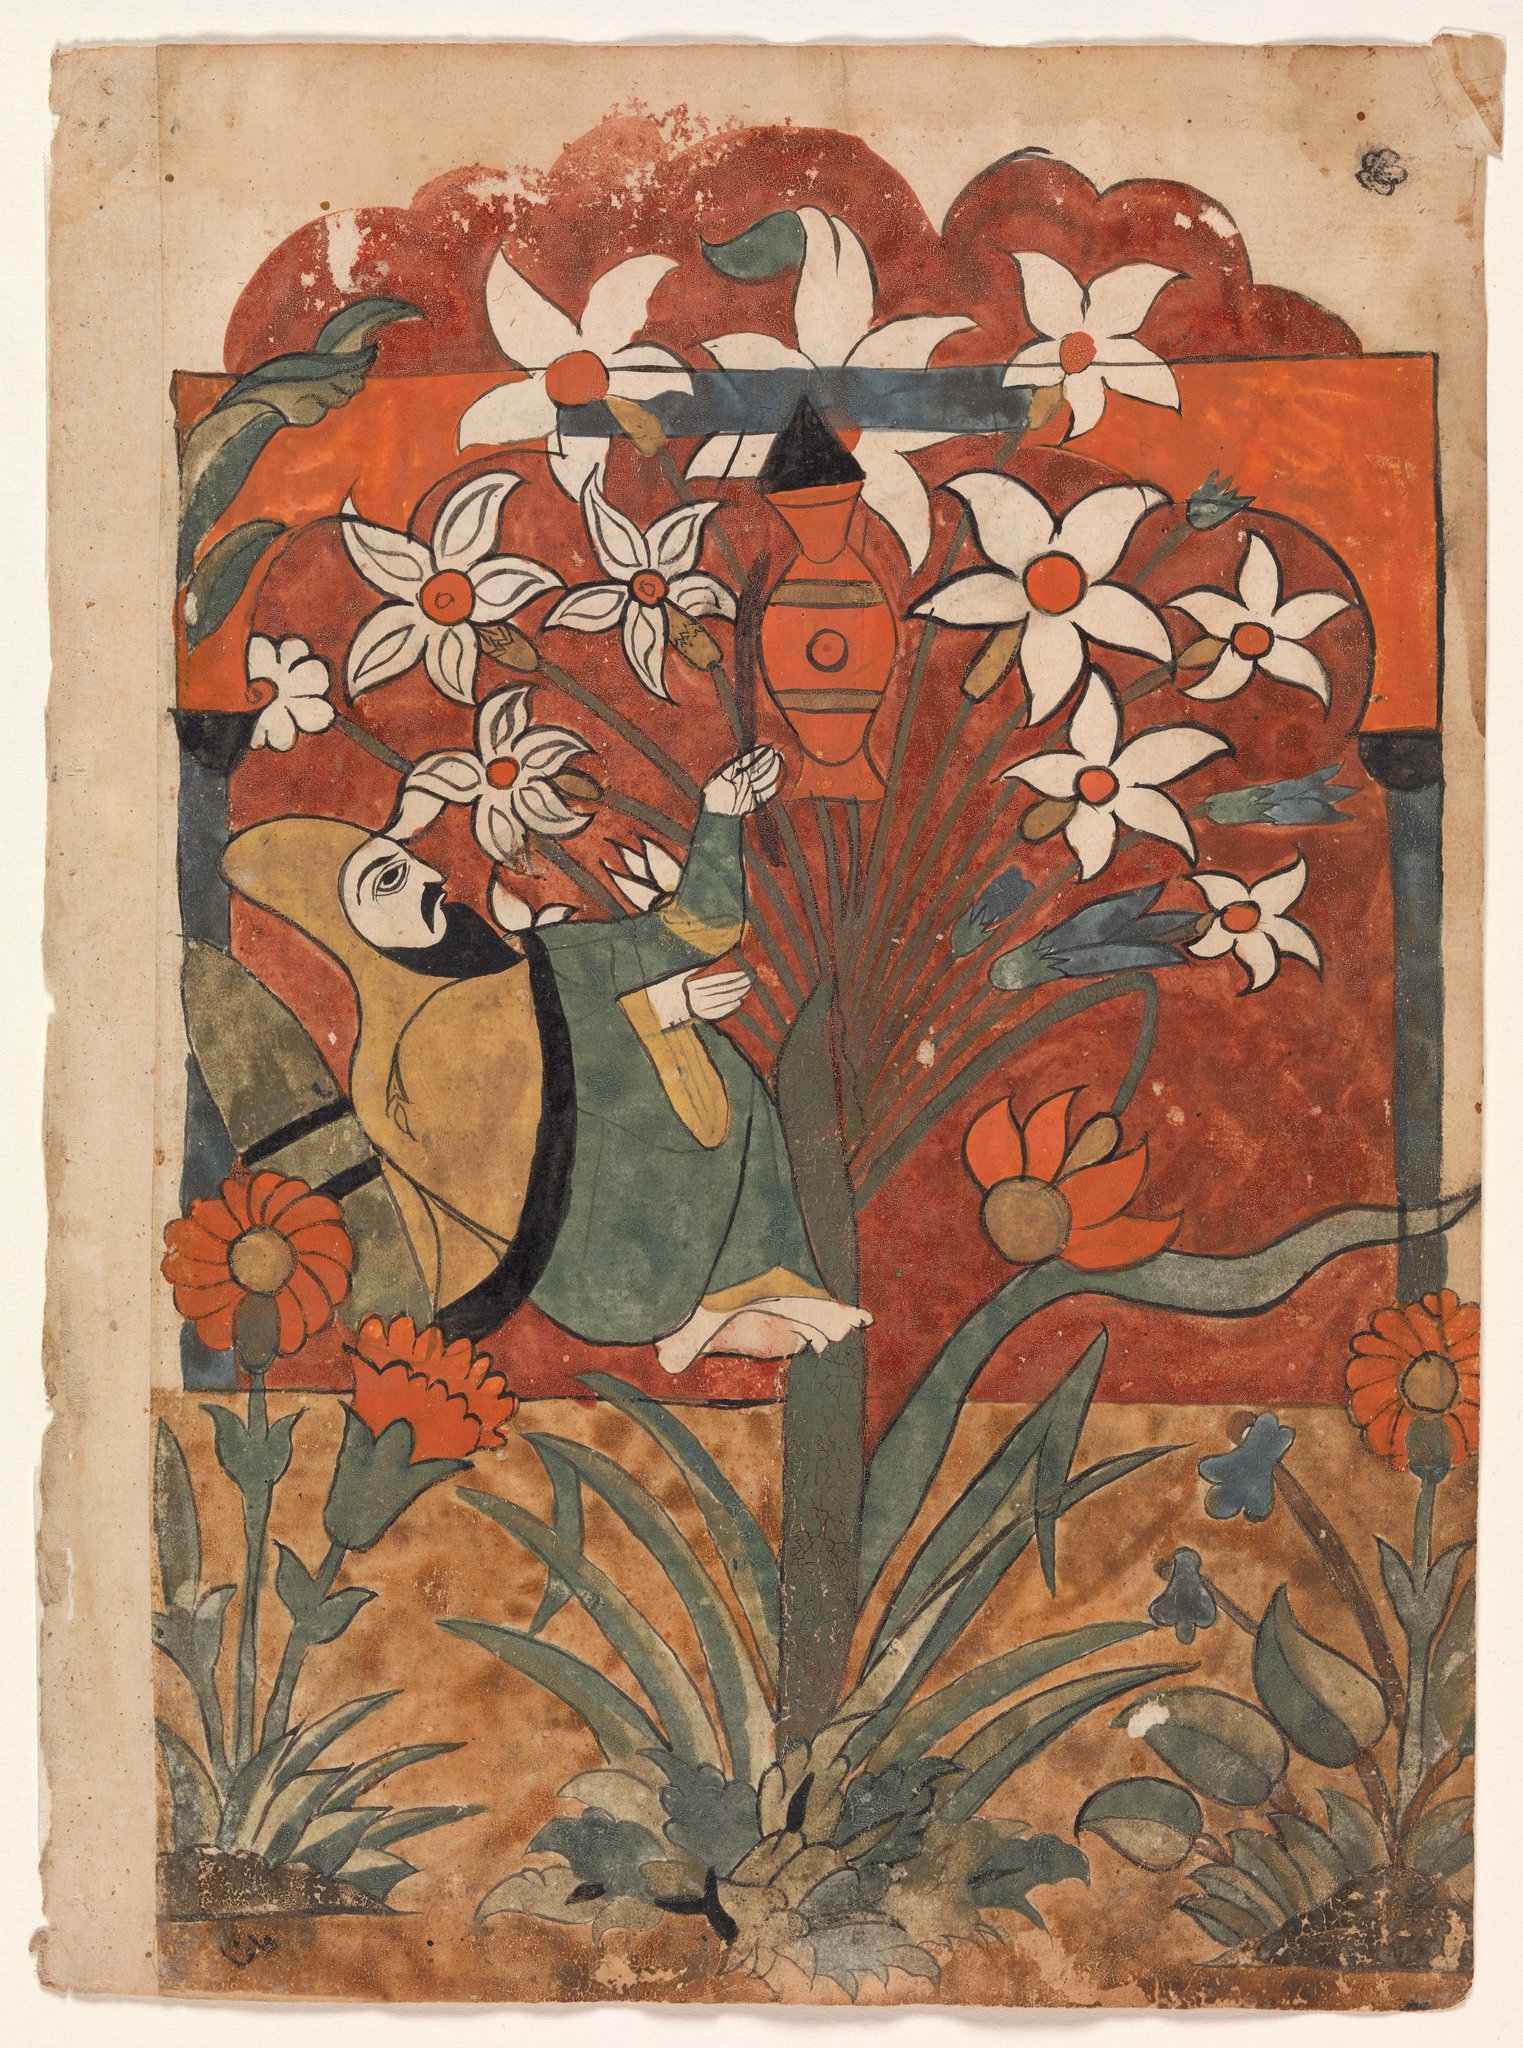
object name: folio from an illustrated manuscript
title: "The Ascetic Strikes a Jar of Honey and Oil with his Staff While Daydreaming", Folio from a Kalila wa Dimna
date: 1526-1550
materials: ink, paper, watercolor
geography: india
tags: men,flowers,plants